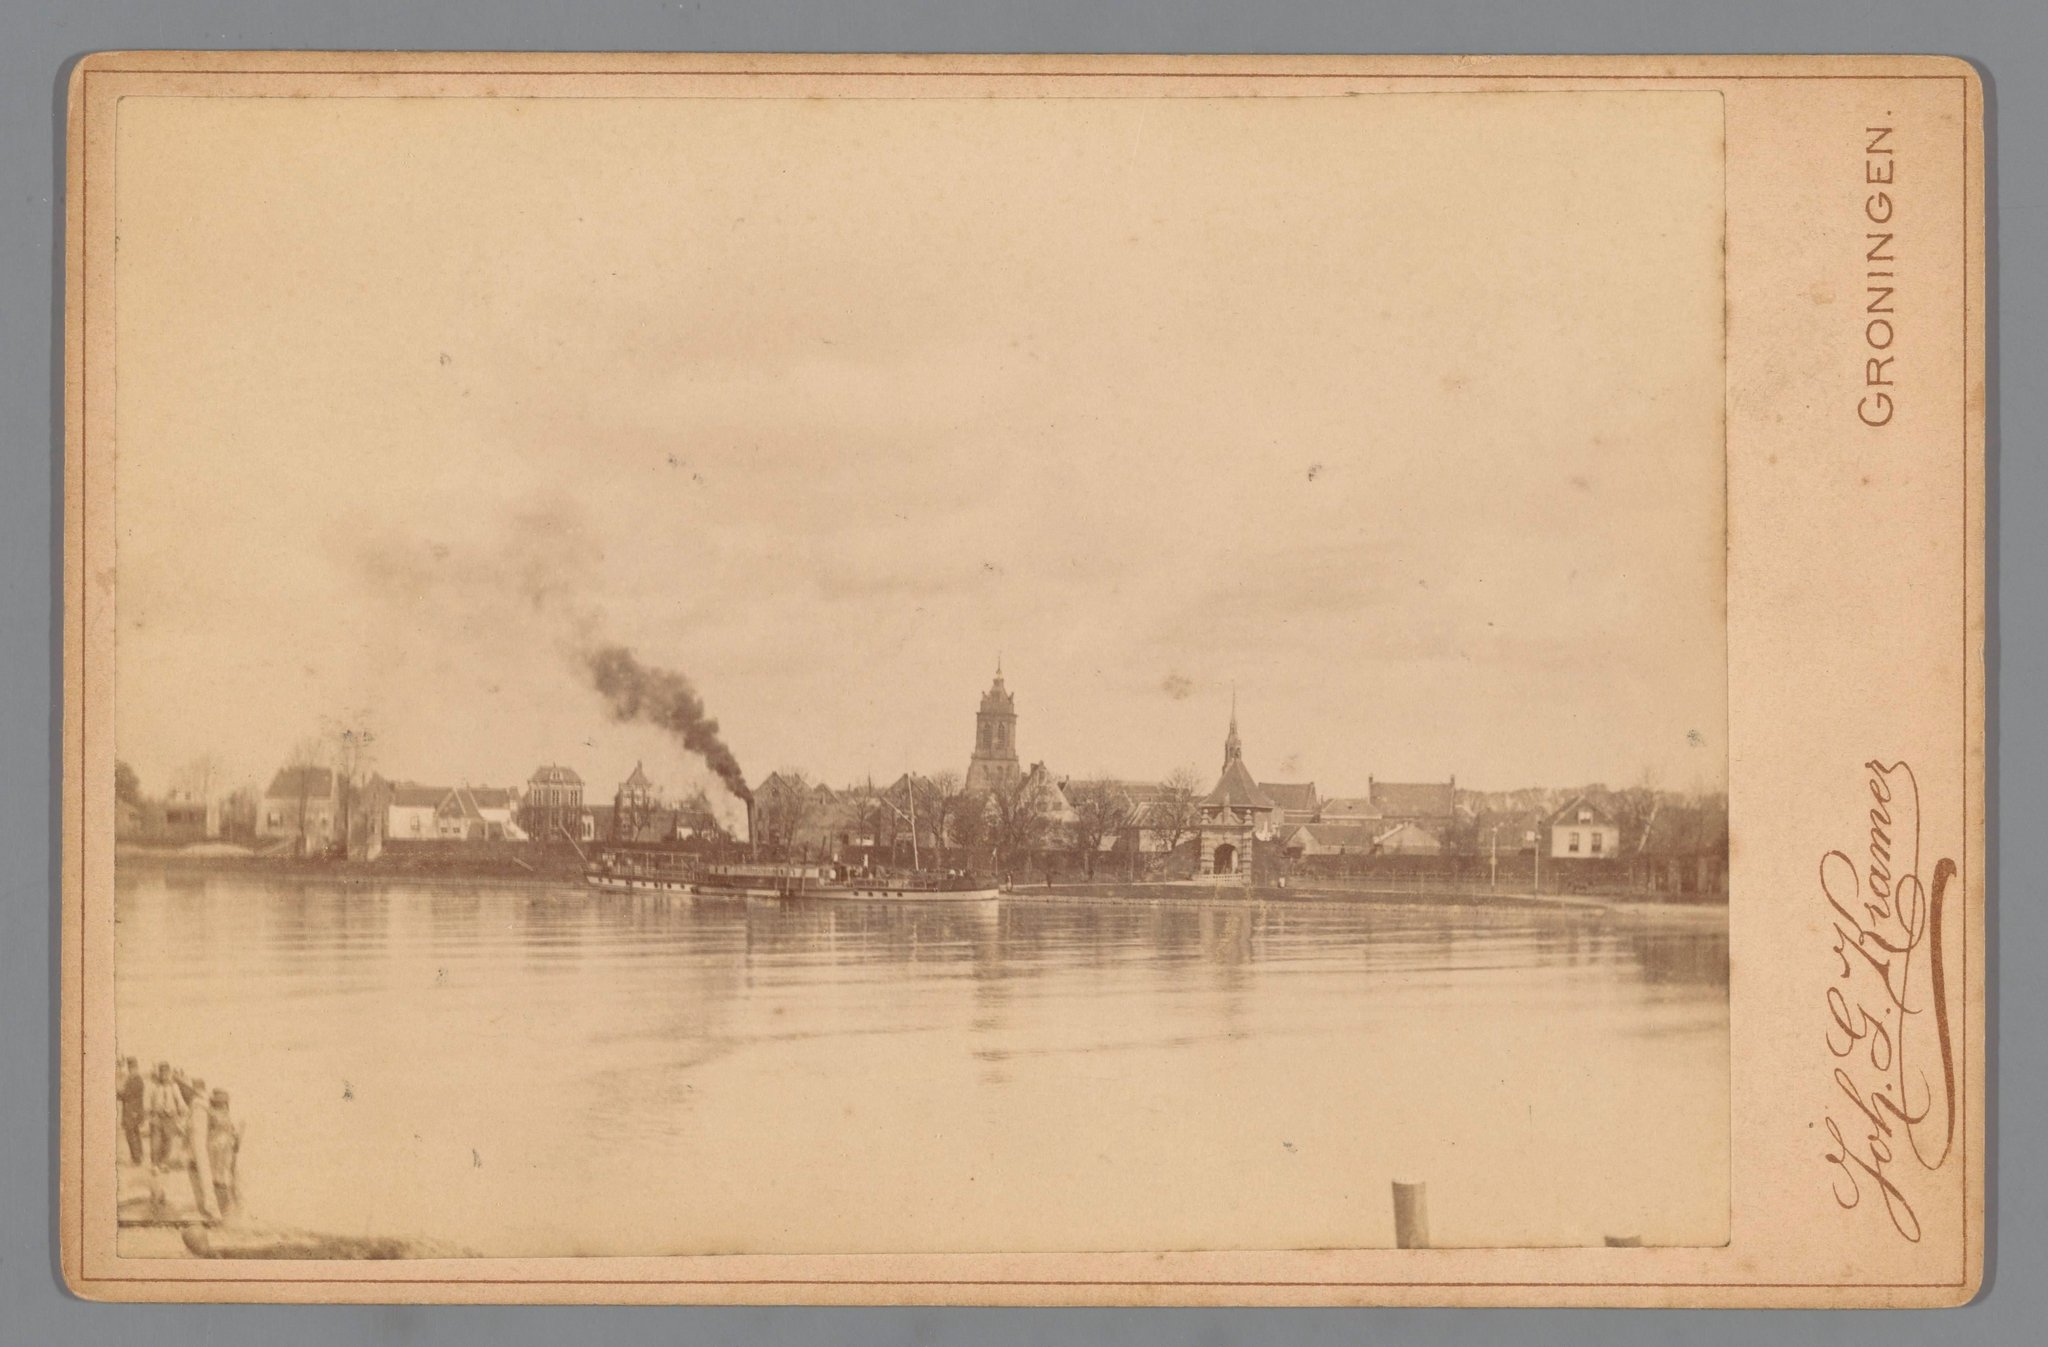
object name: cabinet photograph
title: Nieuwe photographiën van Schoonhoven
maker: johannes gerardus kramer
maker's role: fotograaf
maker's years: 1845-1903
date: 1888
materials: cardboard, photographic support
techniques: albumen print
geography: schoonhoven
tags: prospect of city, town panorama, silhouette of city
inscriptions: inscription: ‘Joh. G. Kramer/ Groningen/ No. Academieplein./ Het negativ blijft ter nabestelling bewaard./ Trapp & Münch Berlin.’, name: ‘Joh. G. Kramer GRONINGEN.’